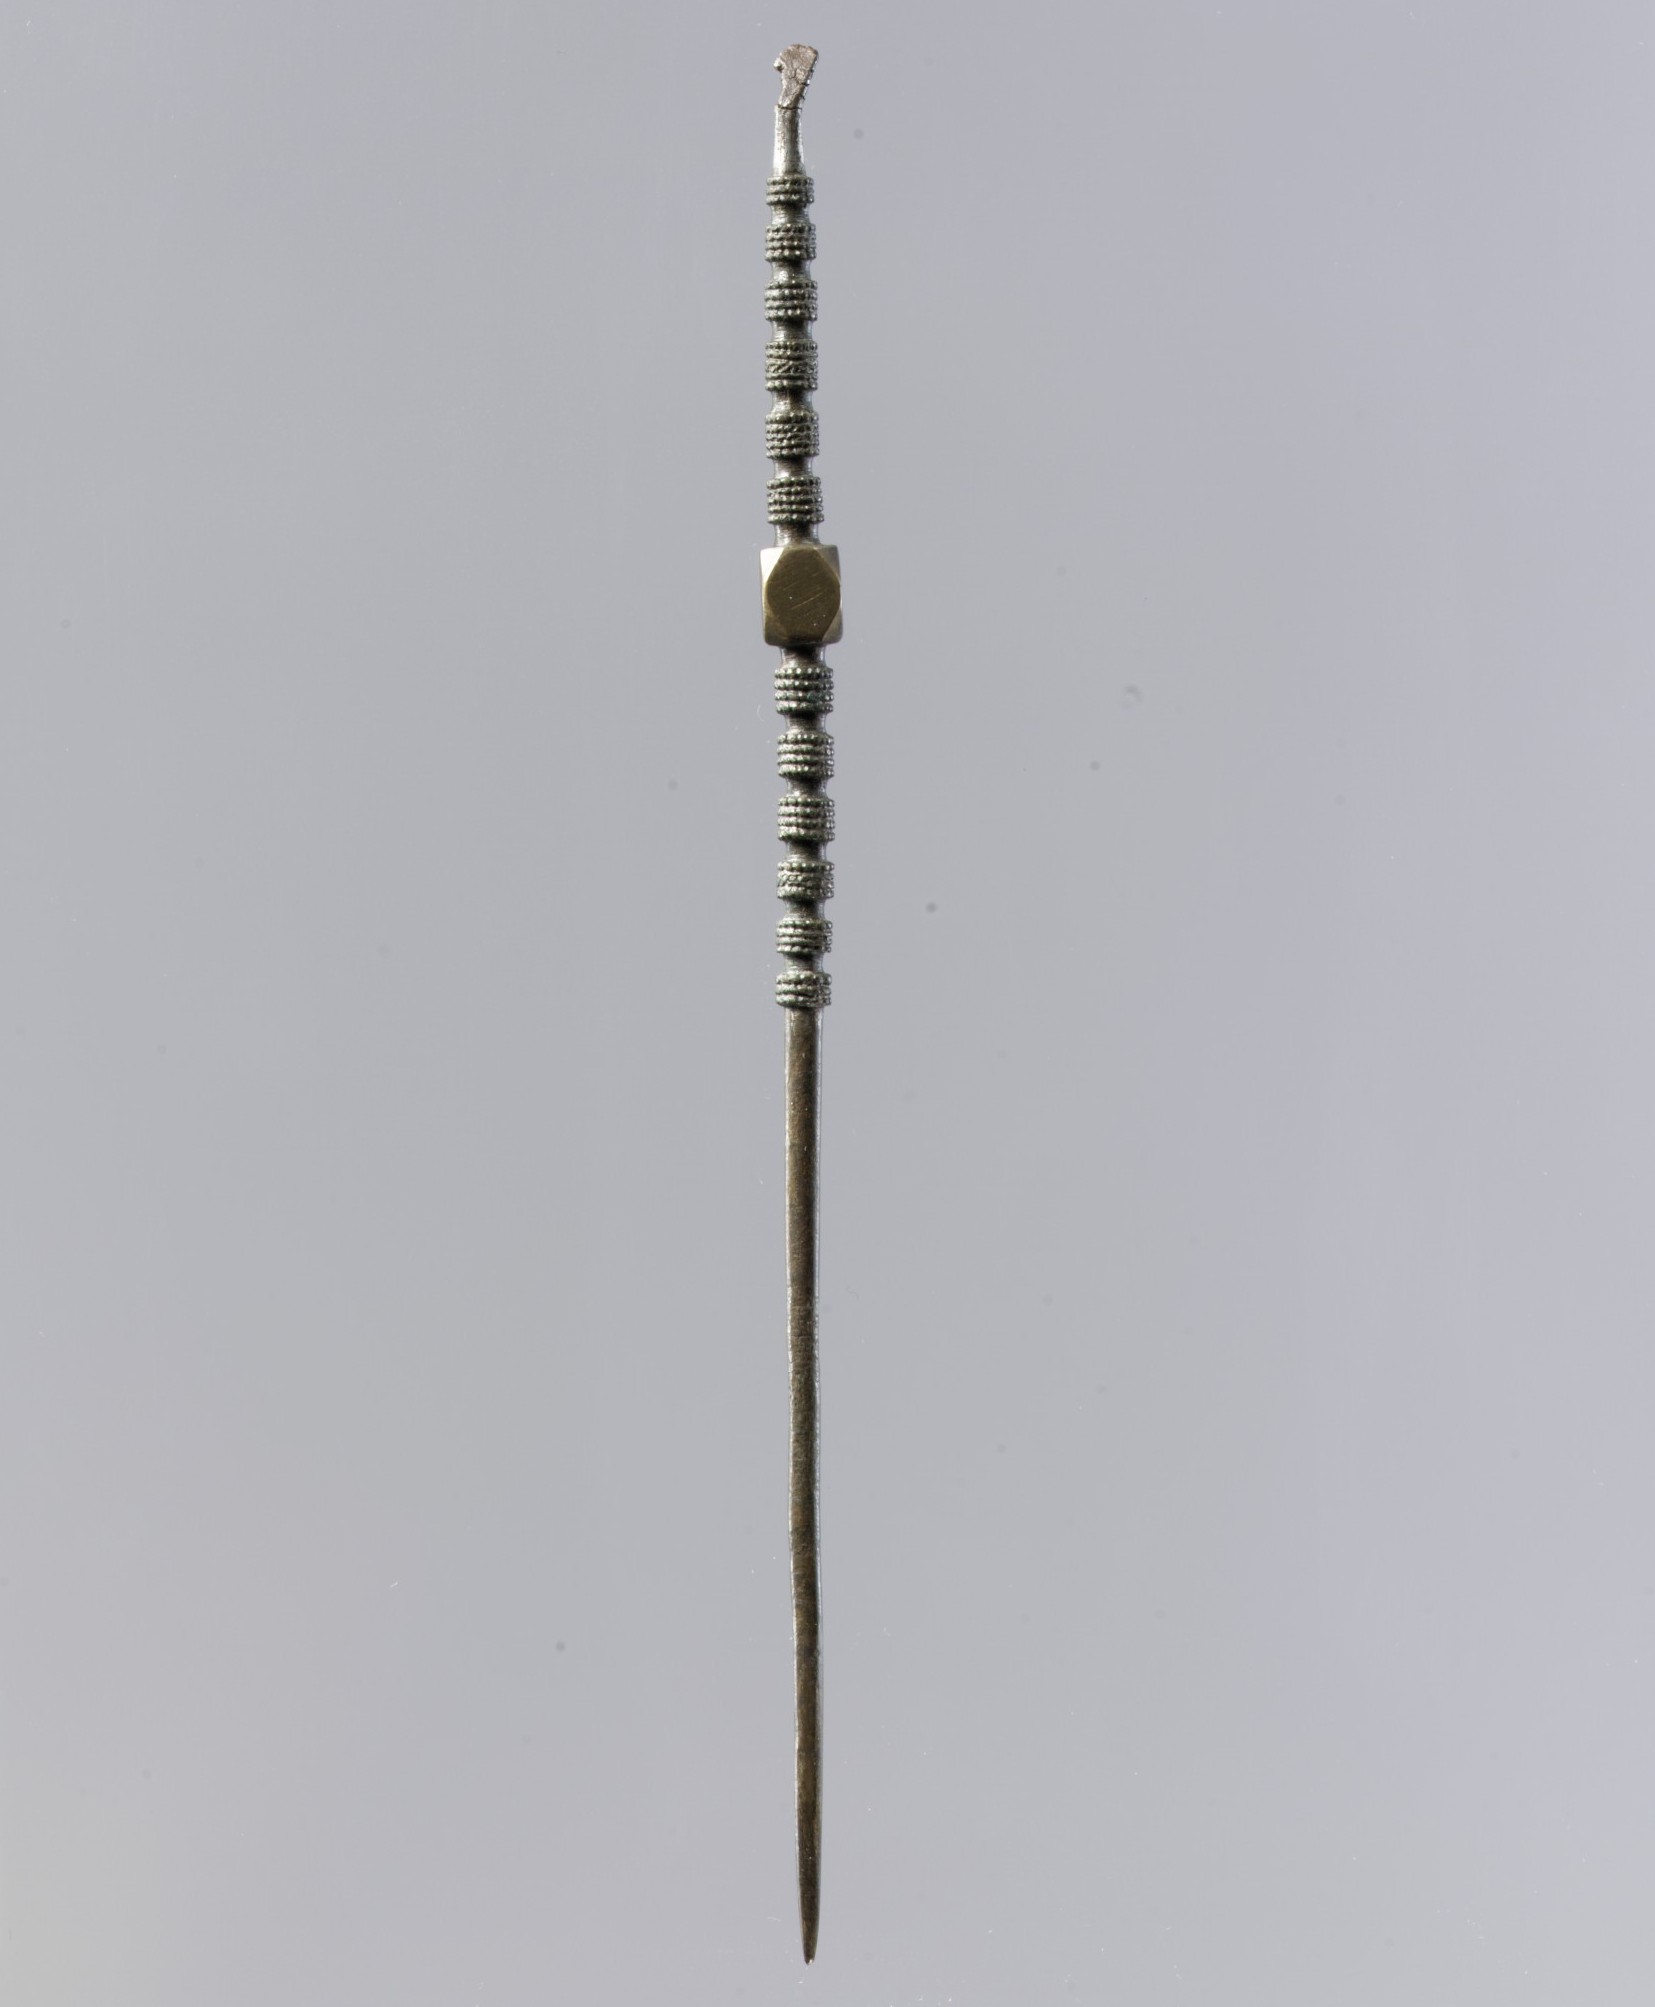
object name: hairpin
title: Pin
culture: frankish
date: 601-700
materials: copper alloy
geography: northern france